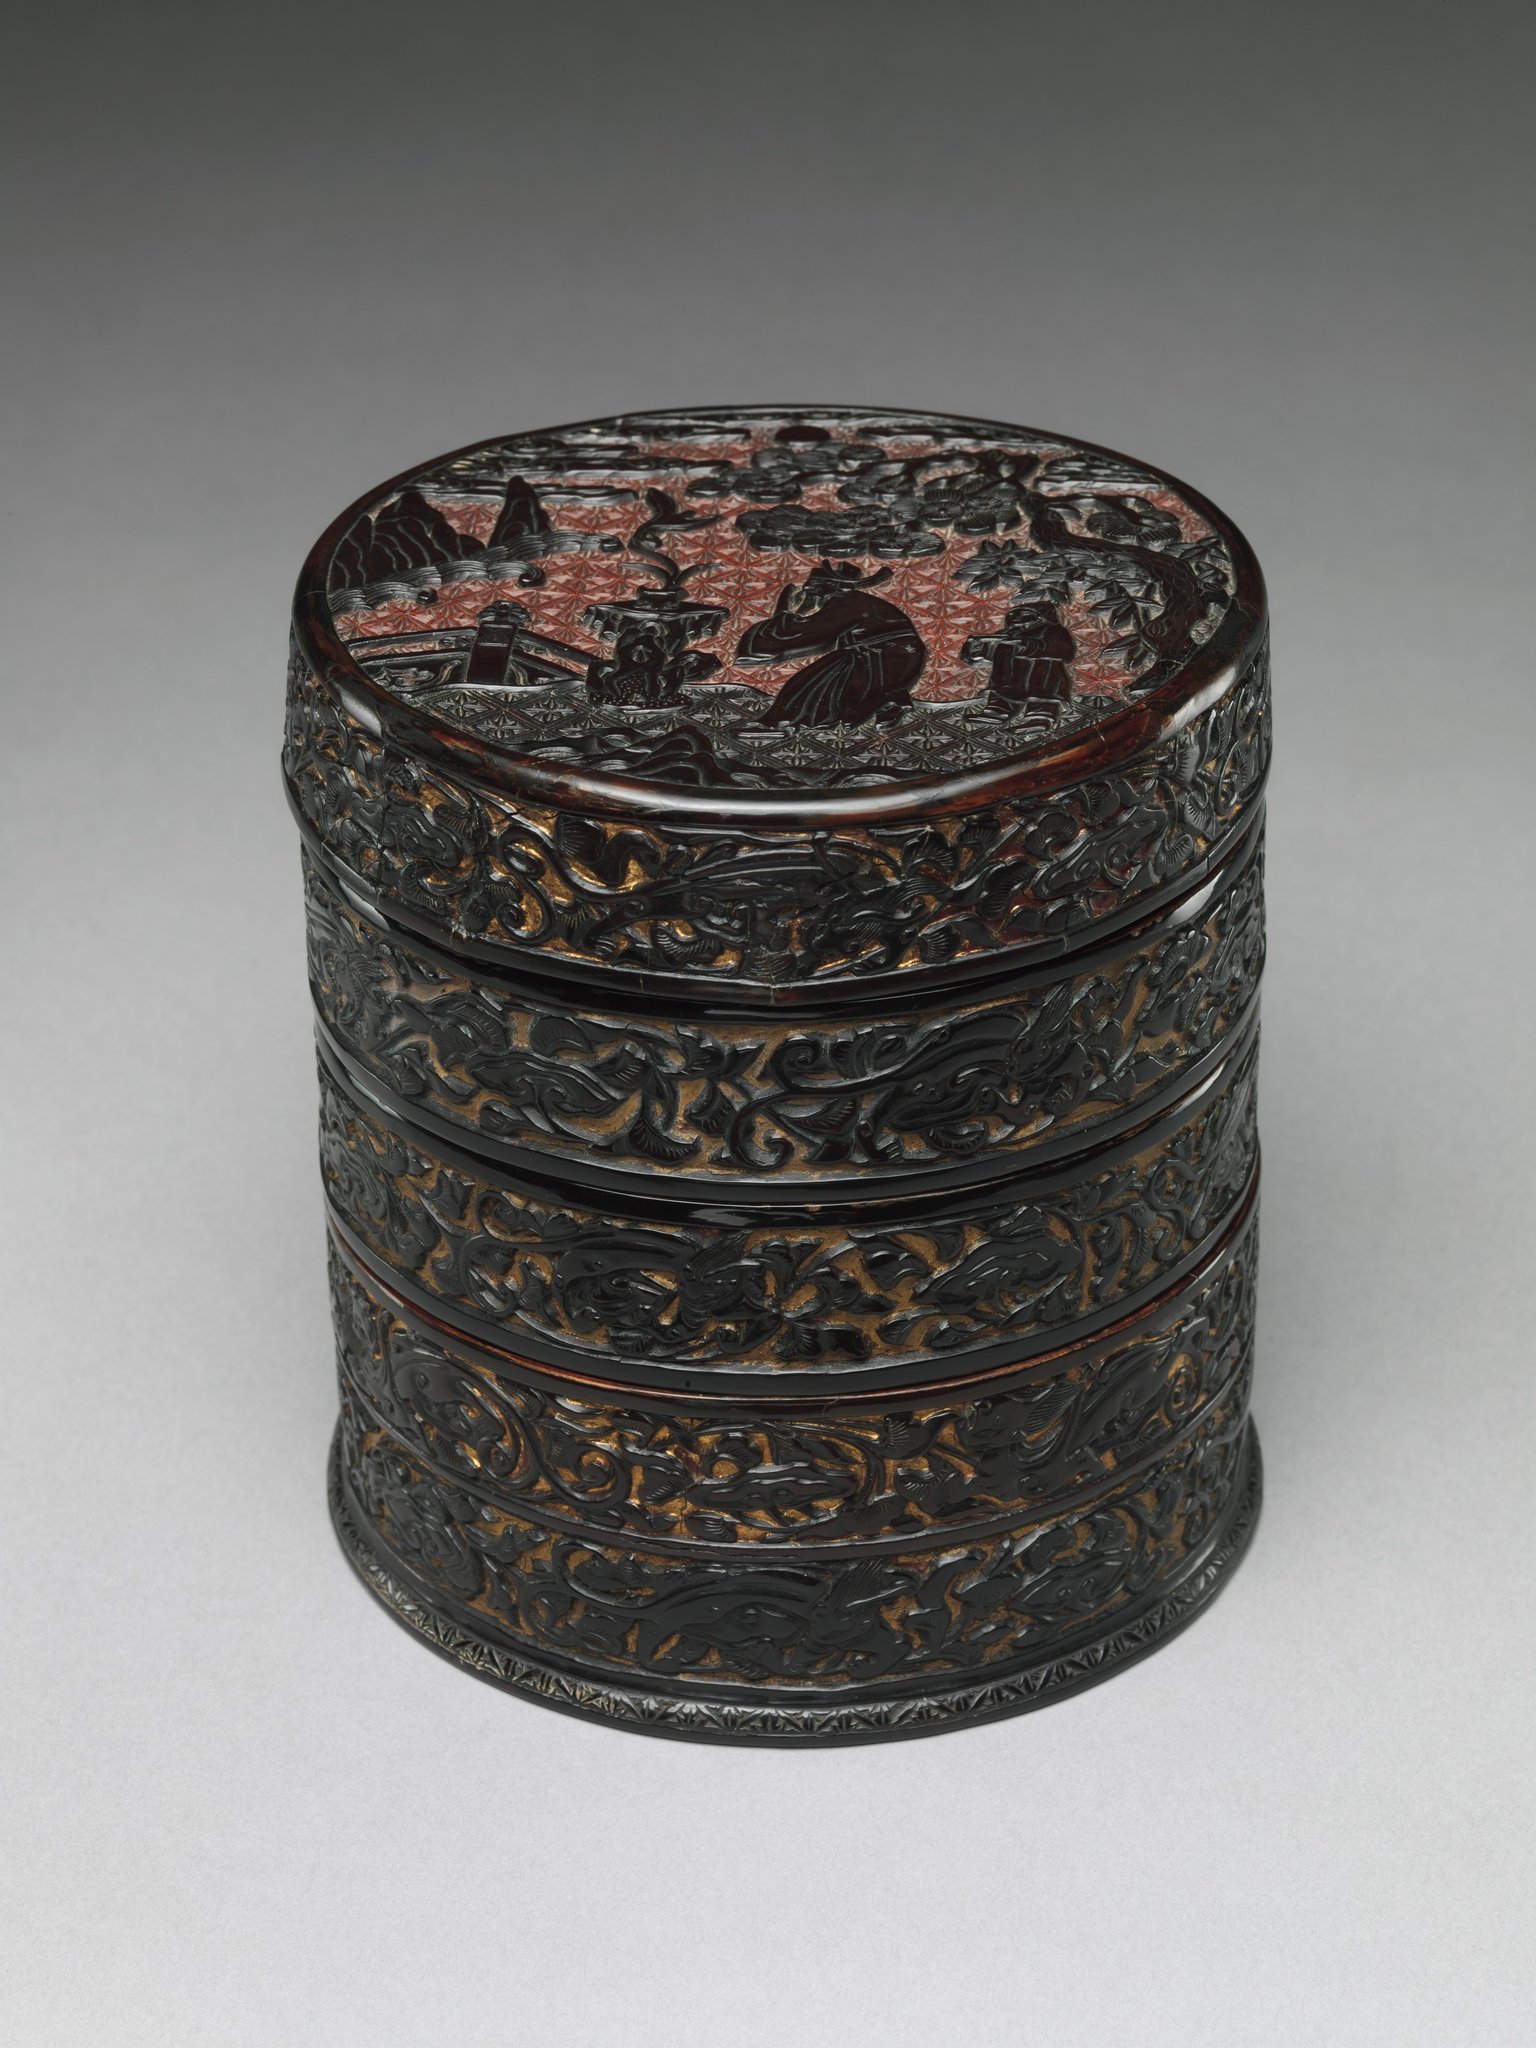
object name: tiered box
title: Tiered box with a praying official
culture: chinese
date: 1367-1400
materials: lacquer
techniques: carving, gilding